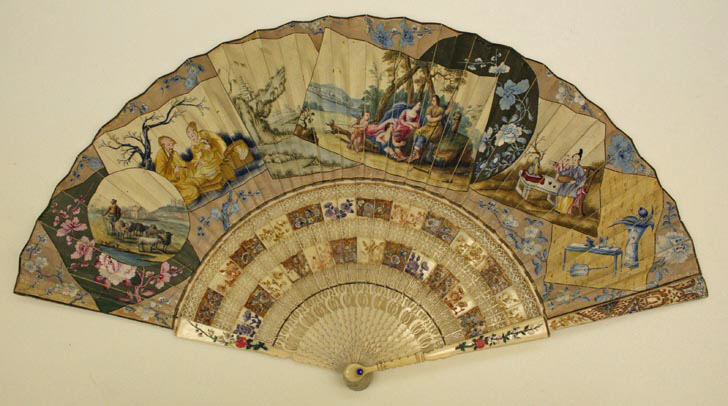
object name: fan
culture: european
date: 1701-1800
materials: paint, paper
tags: men,women,landscapes